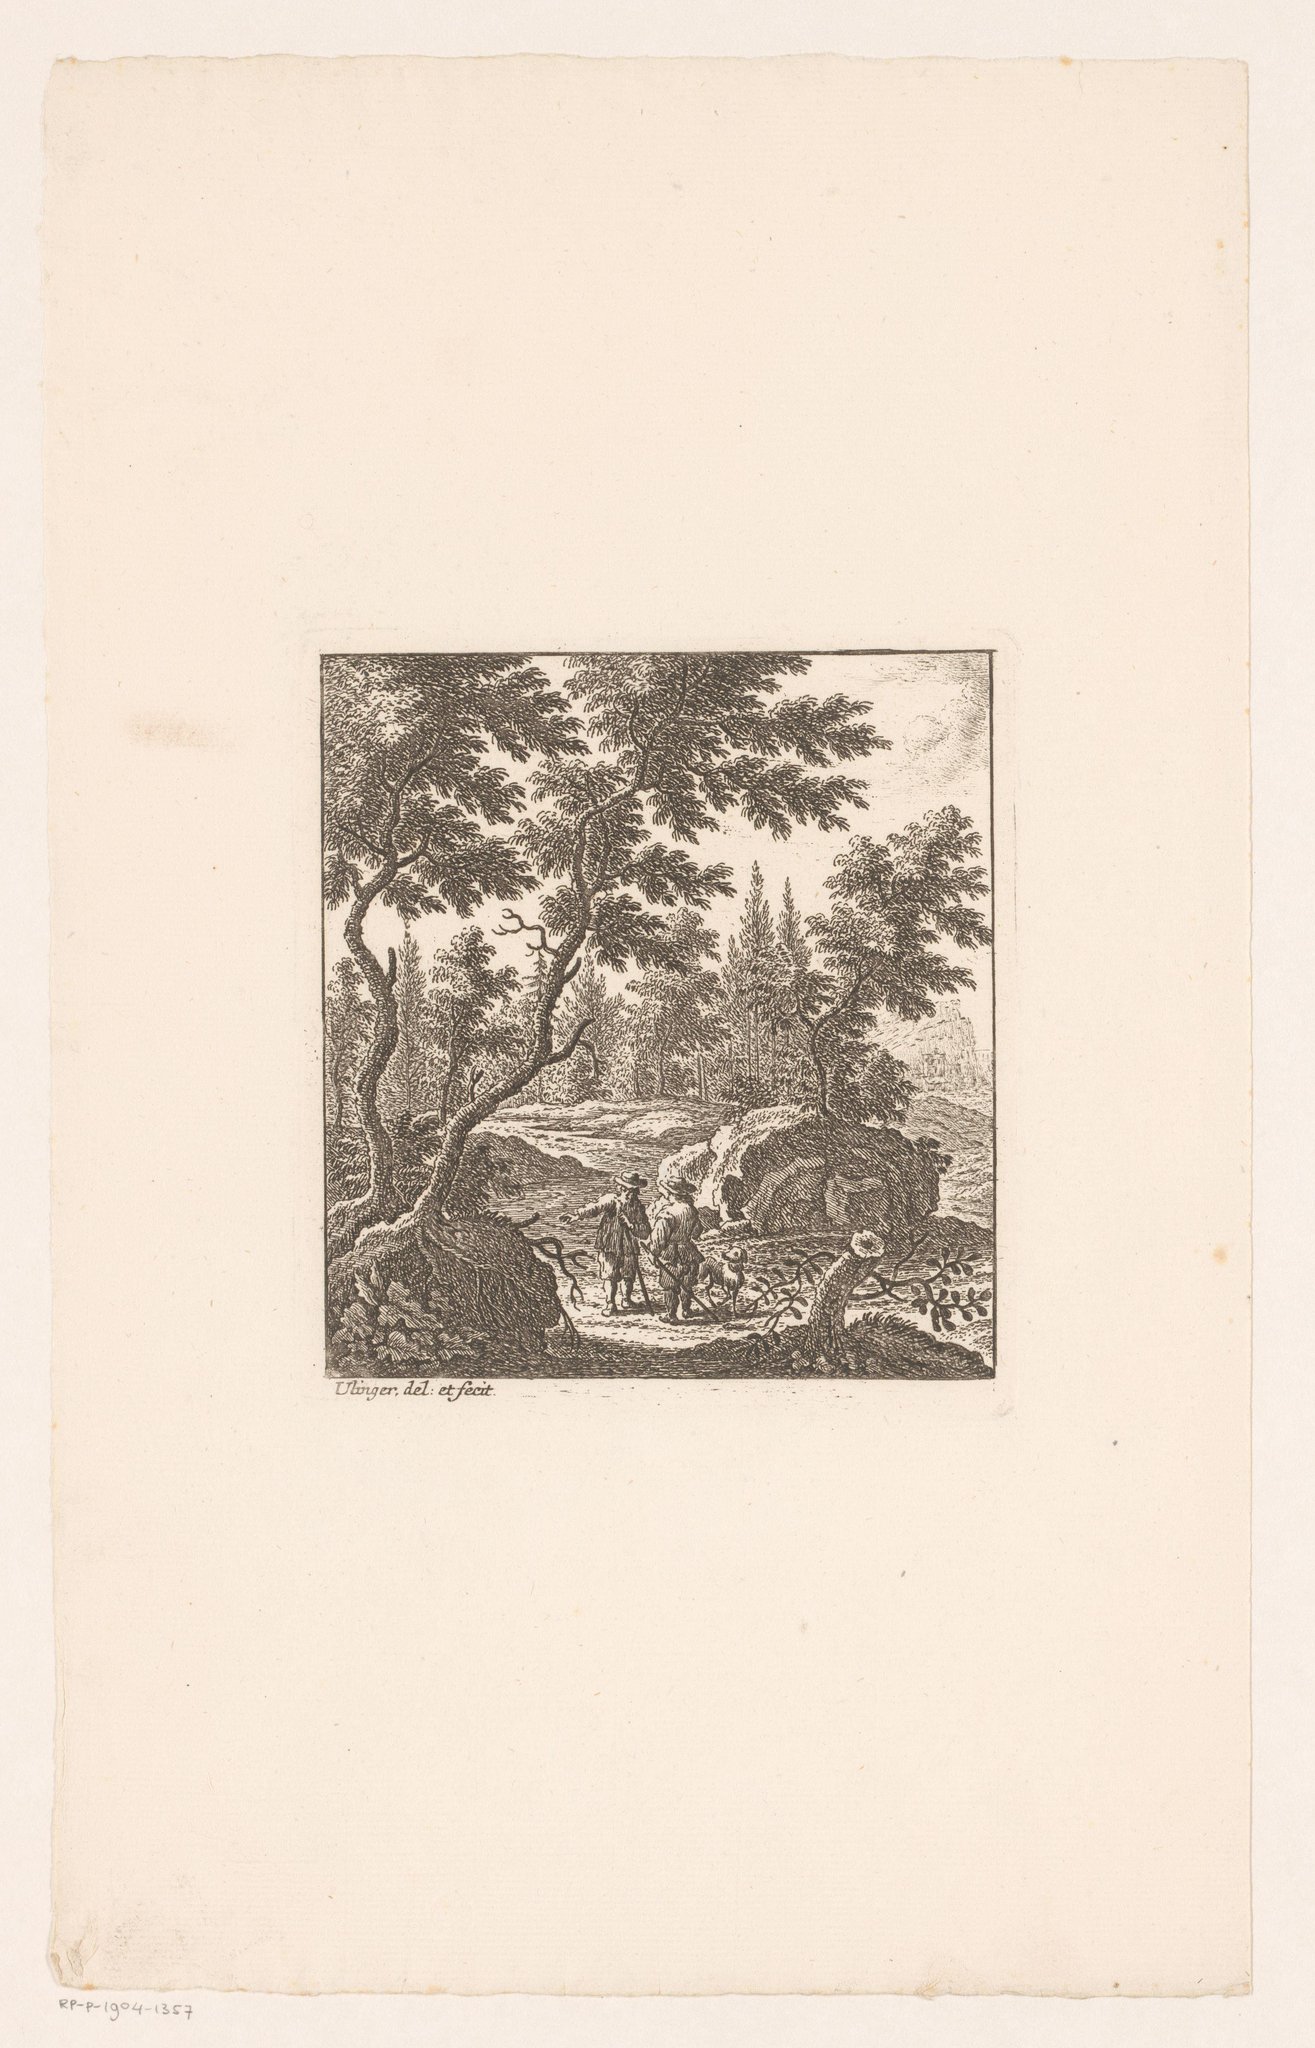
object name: print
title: Bosrijk landschap met twee mannen en een hond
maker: johann caspar ulinger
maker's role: painter, print maker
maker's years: 1703-1768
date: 1713-1768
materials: paper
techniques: etching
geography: switzerland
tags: forest, wood, 'en route', traveller under way, dog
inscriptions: collector's mark: Lugt 2228